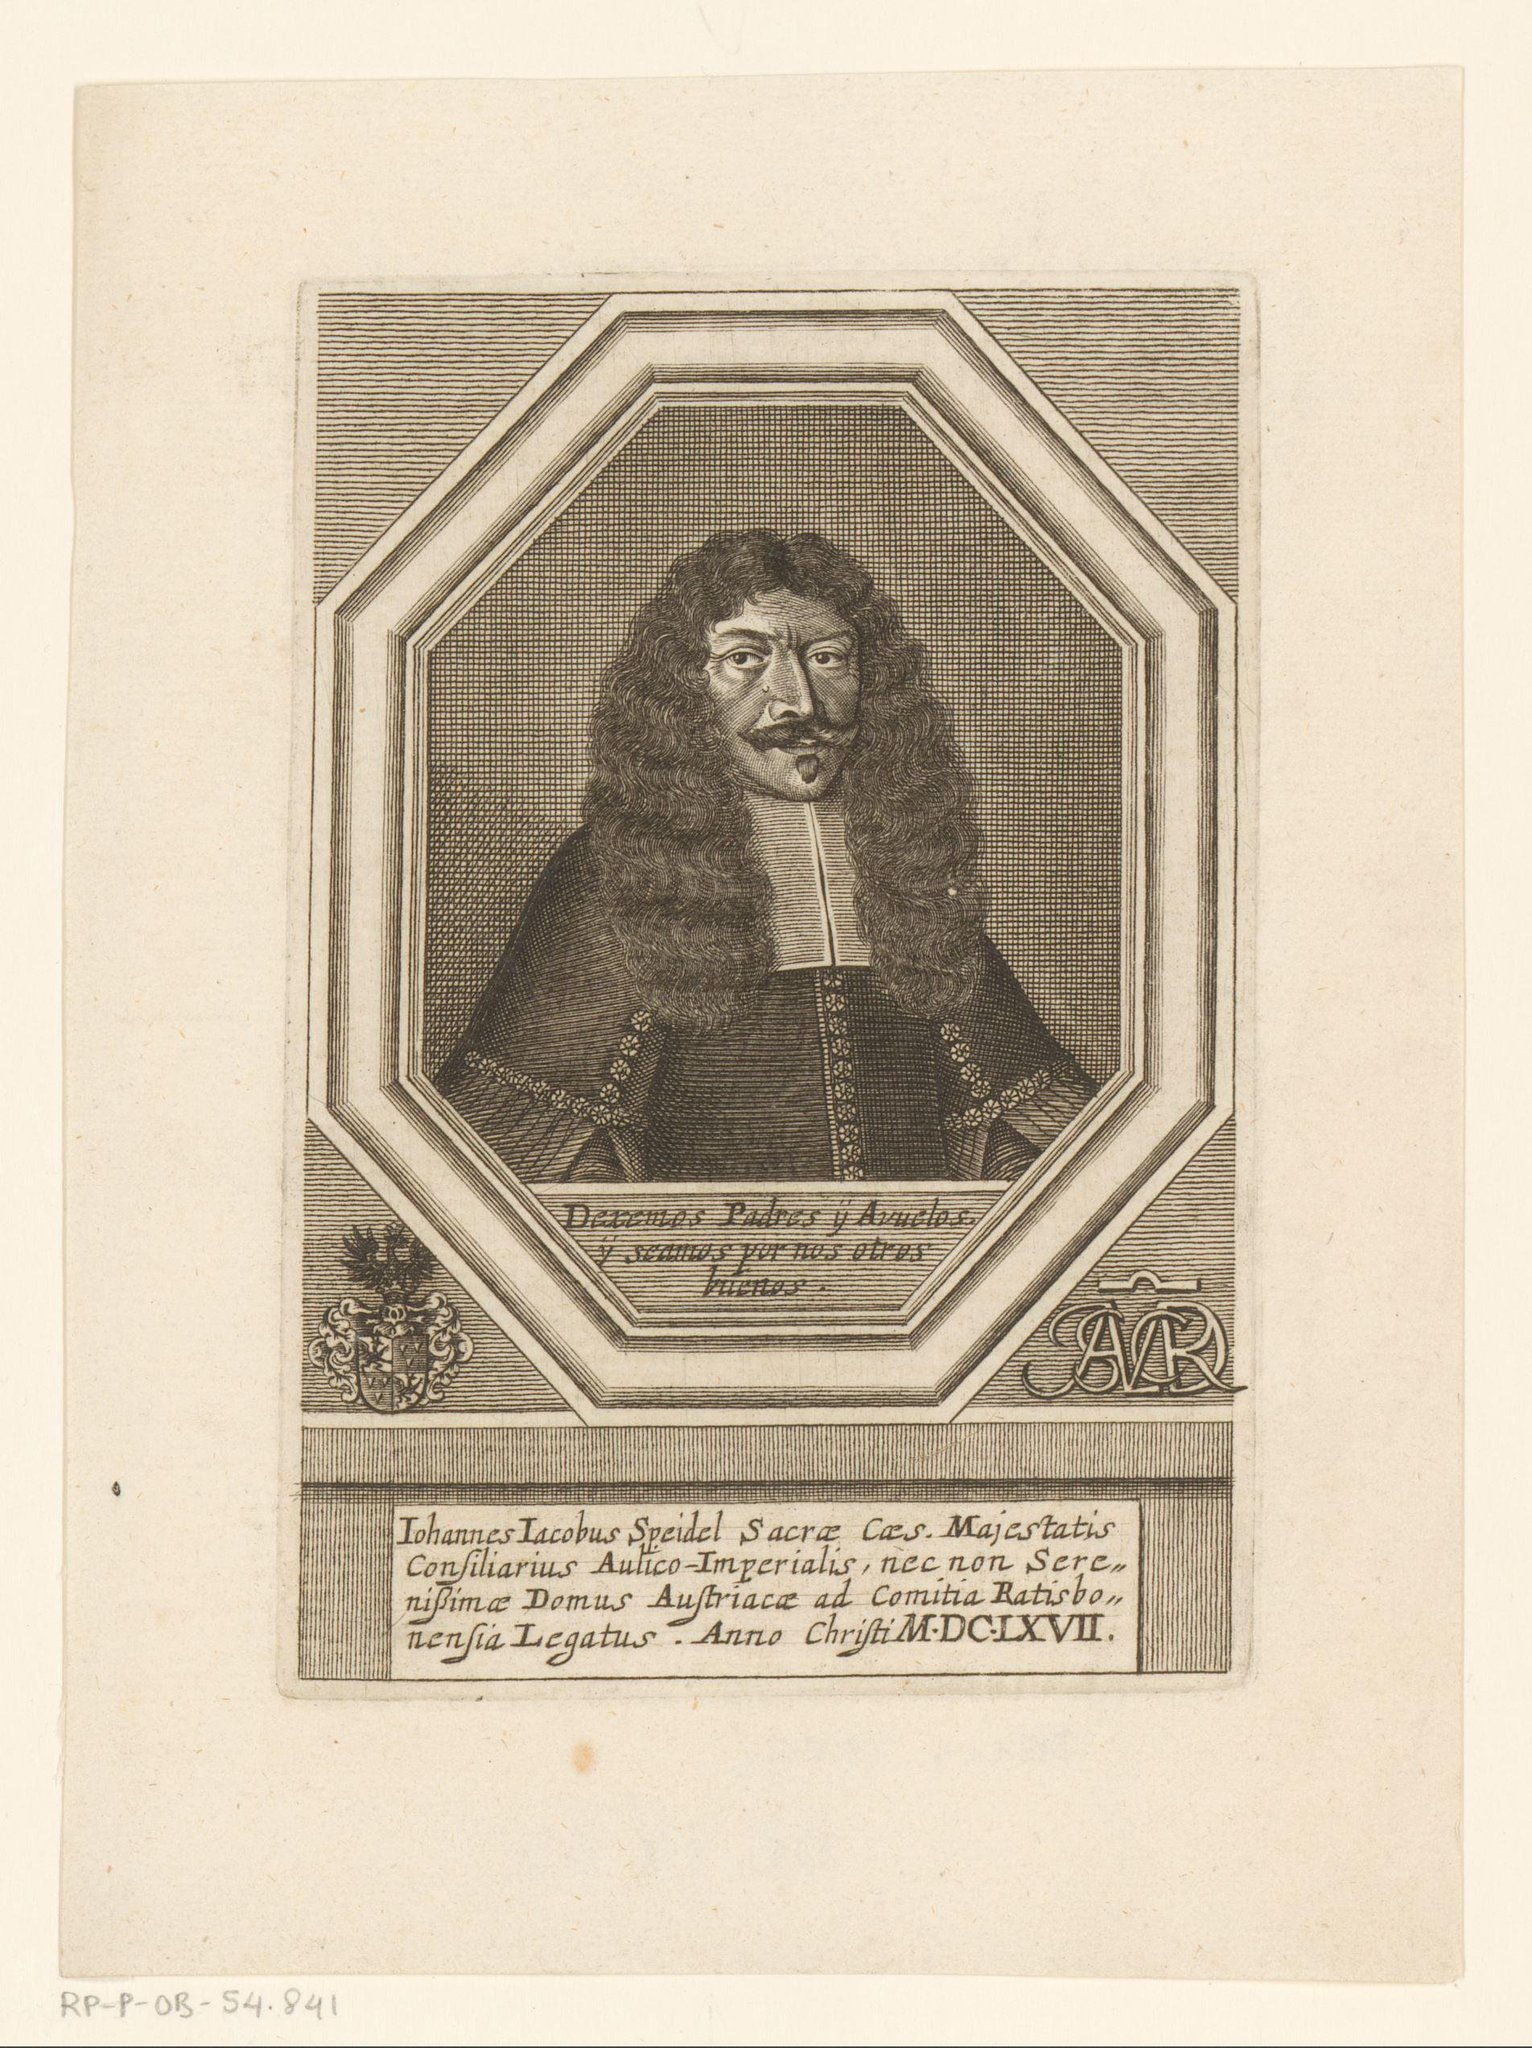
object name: print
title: Portret van Johann Jacob Speidel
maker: matthias van sommer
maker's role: draughtsman, print maker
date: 1667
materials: paper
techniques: engraving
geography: germany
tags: historical persons, armorial bearing, heraldry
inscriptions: collector's mark: Lugt 2228